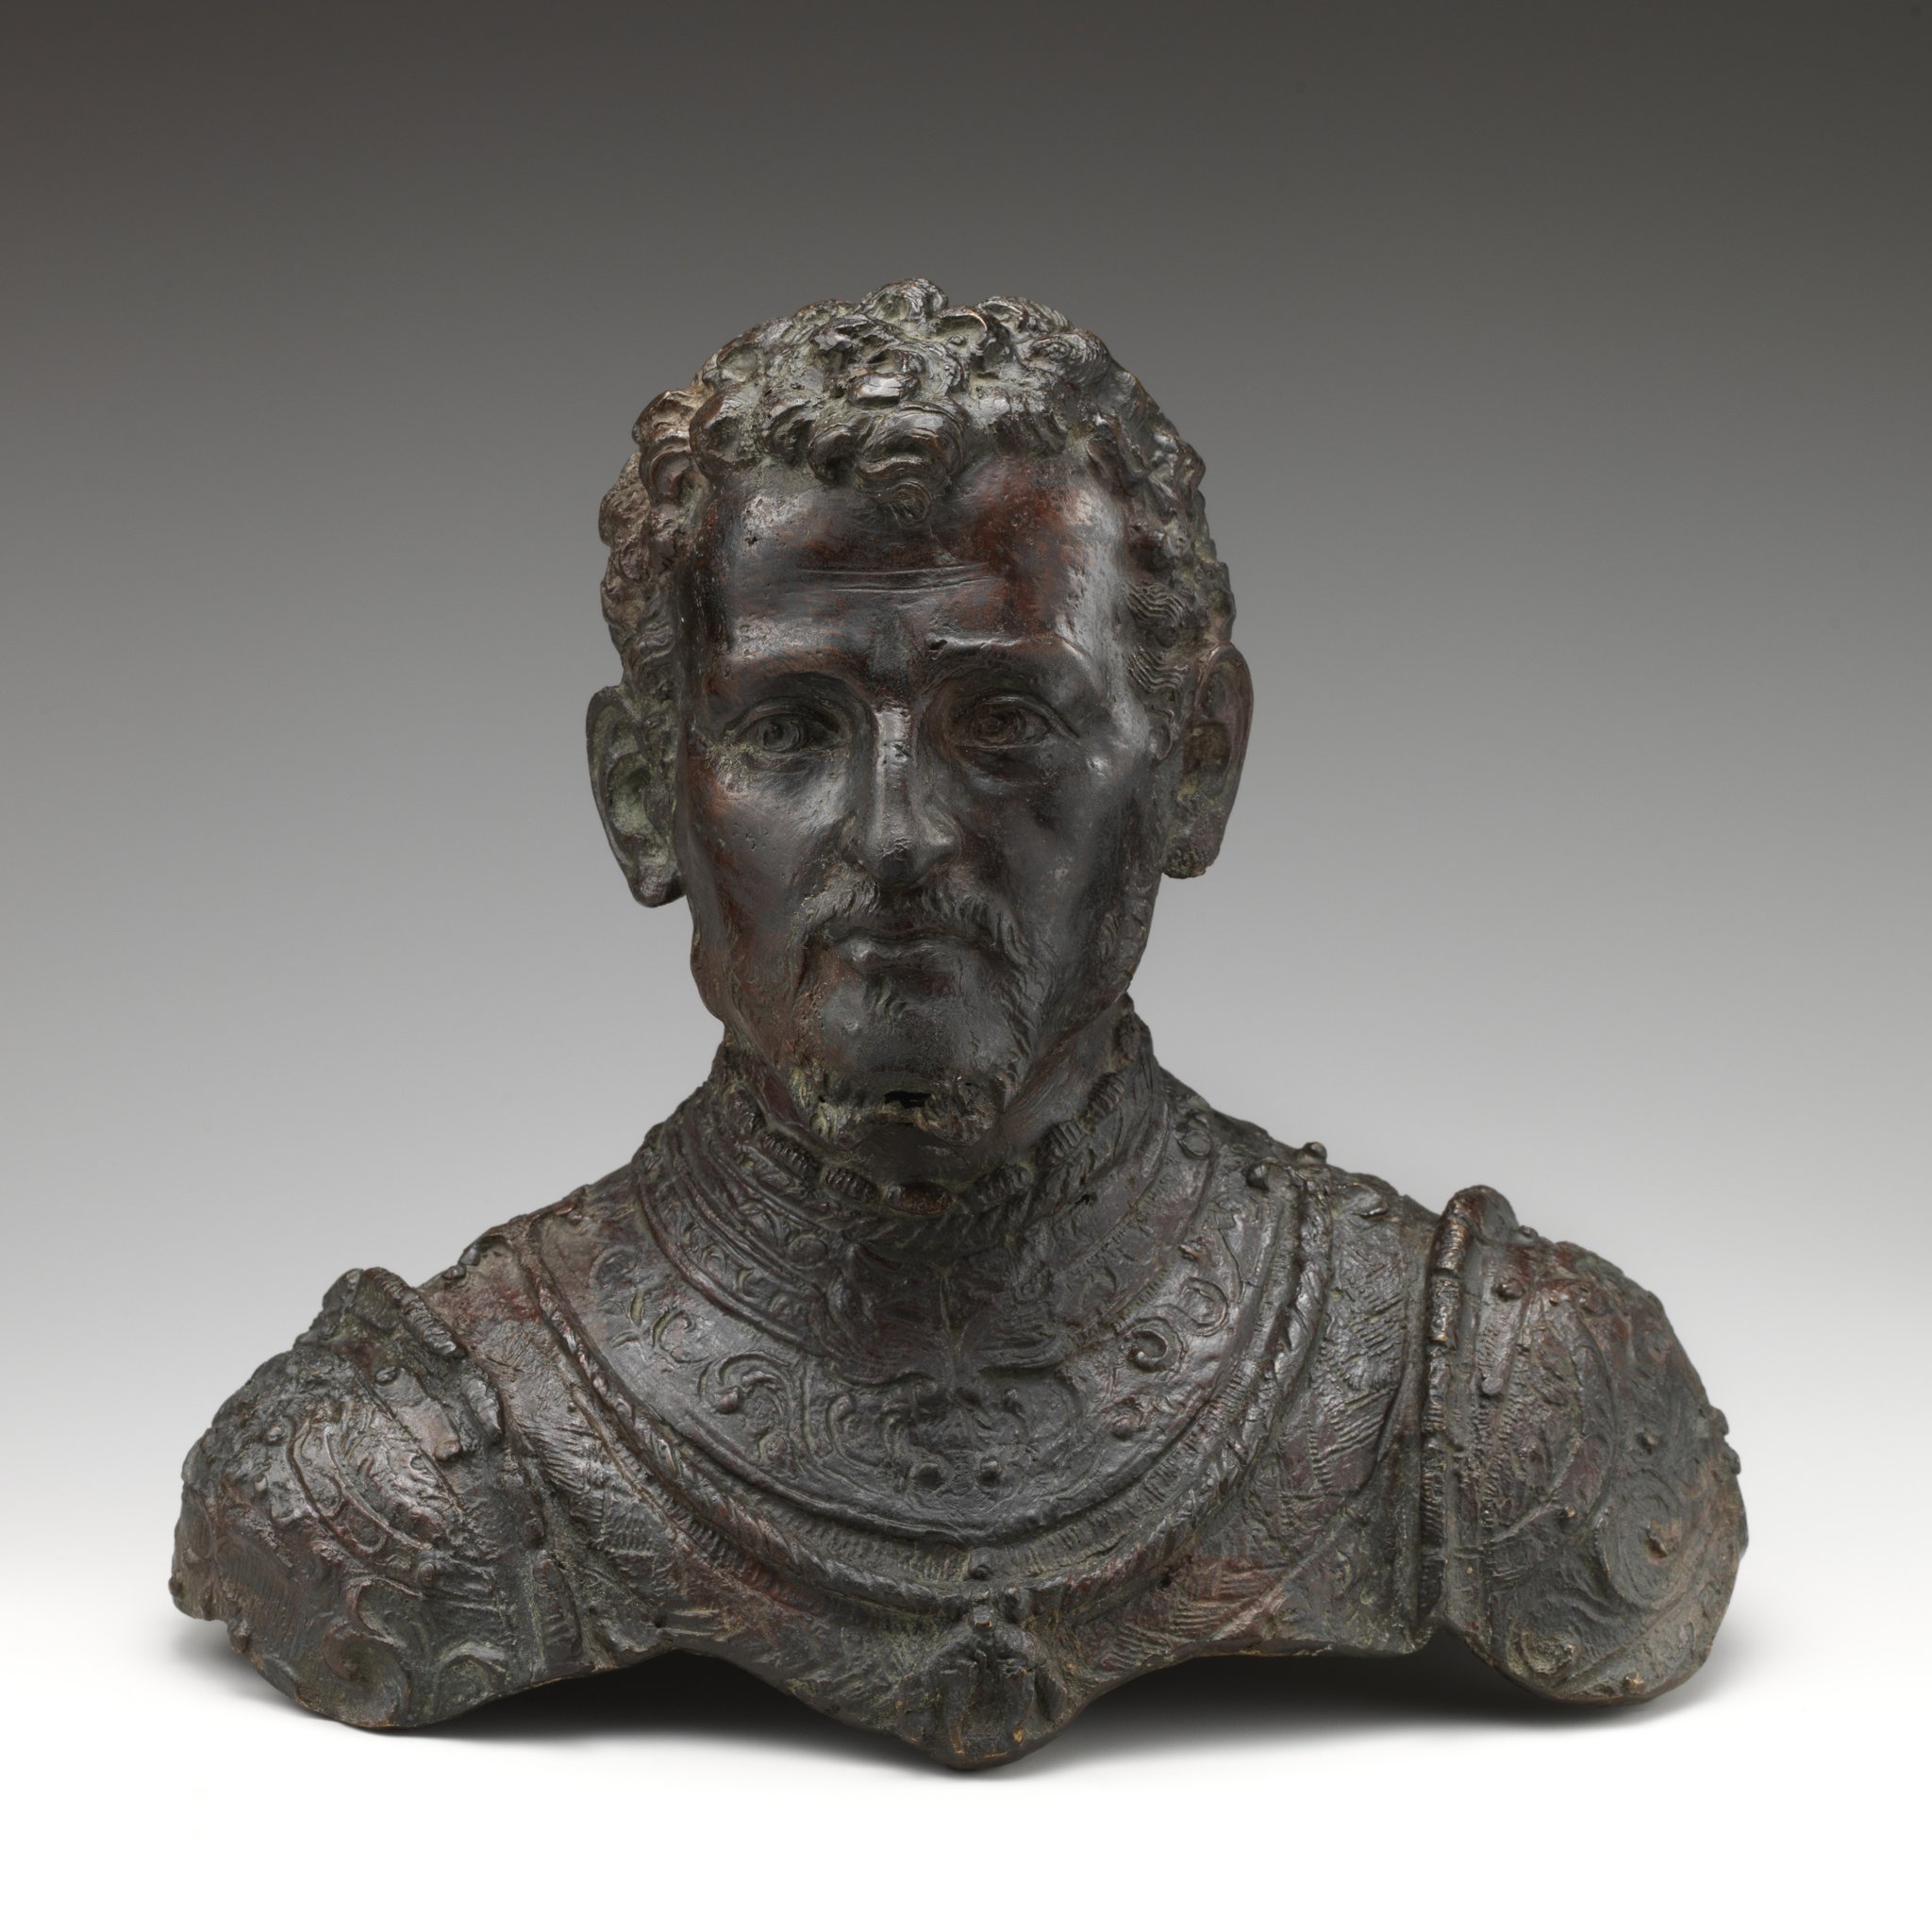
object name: bust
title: Ottavio Farnese, Duke of Parma and Piacenza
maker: pastorino di giovan michele de' pastorini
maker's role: artist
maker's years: 1508-1592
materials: bronze, marble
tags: men,portraits